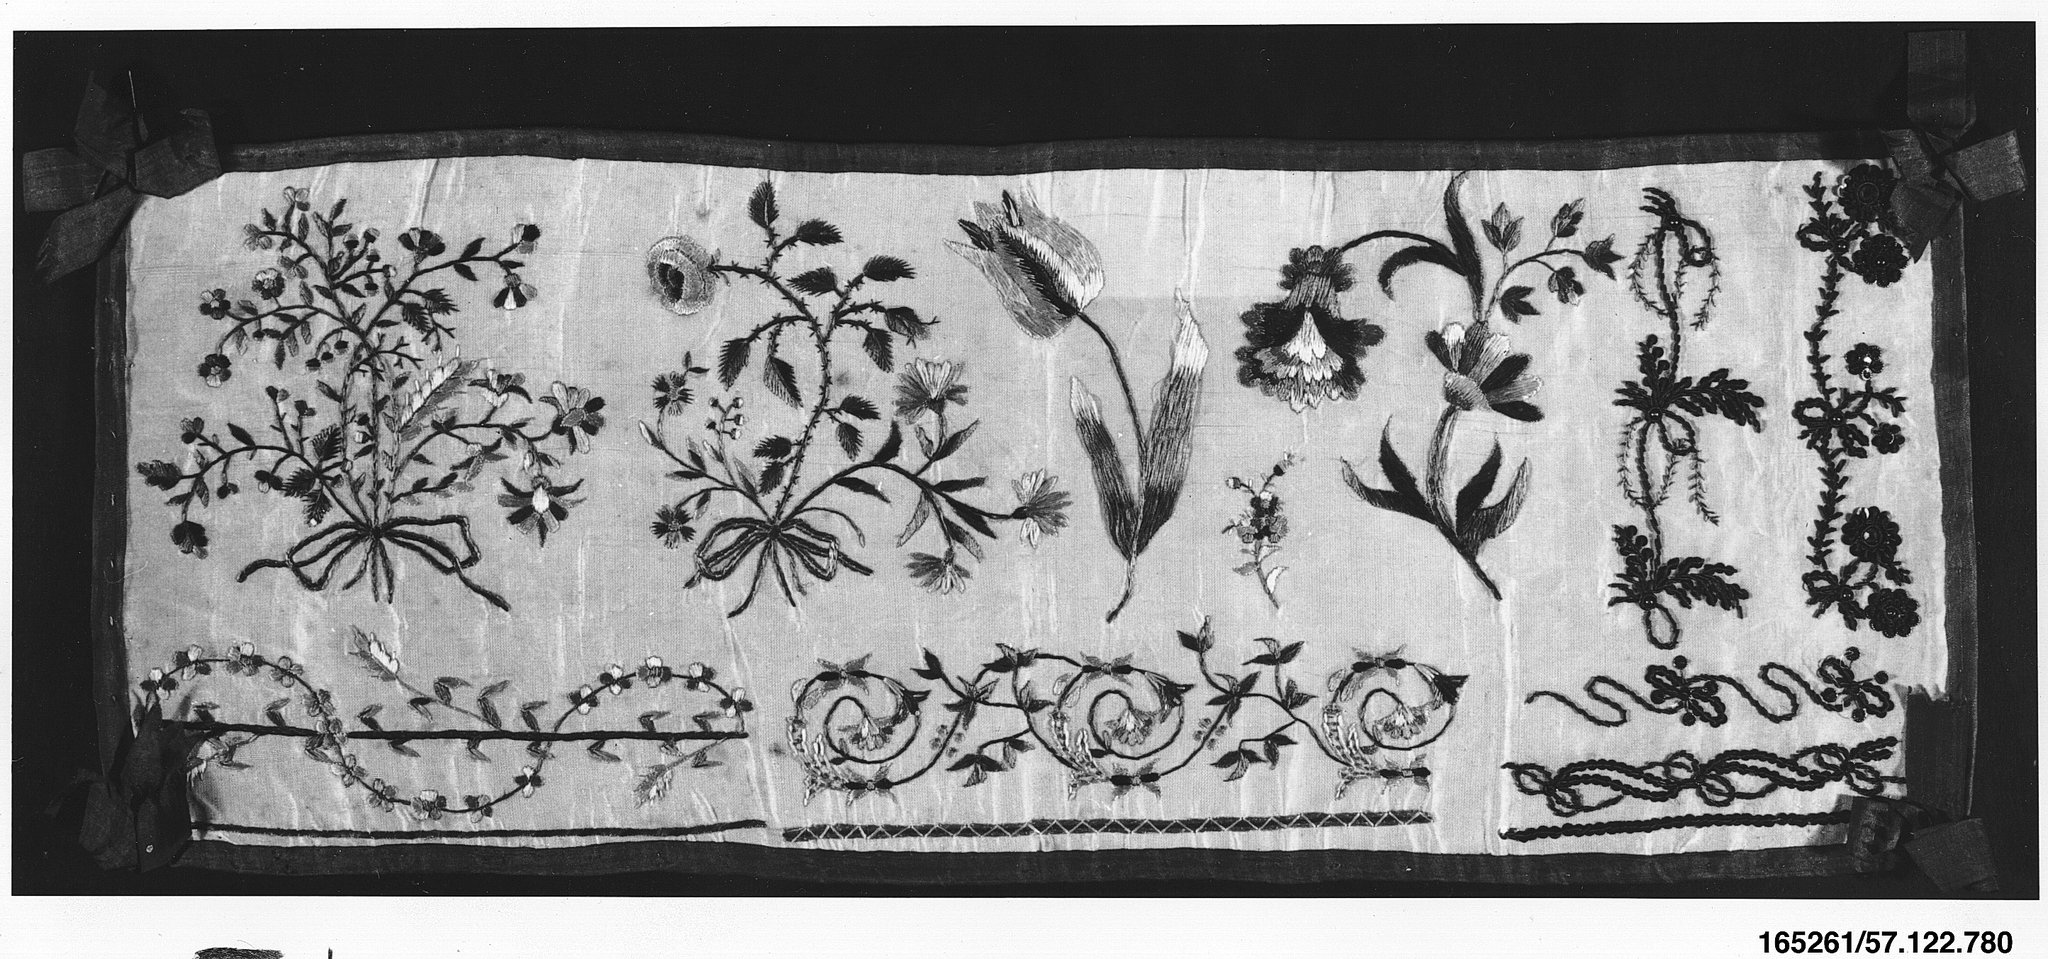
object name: sampler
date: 1701-1800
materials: metal thread, silk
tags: flowers,leaves